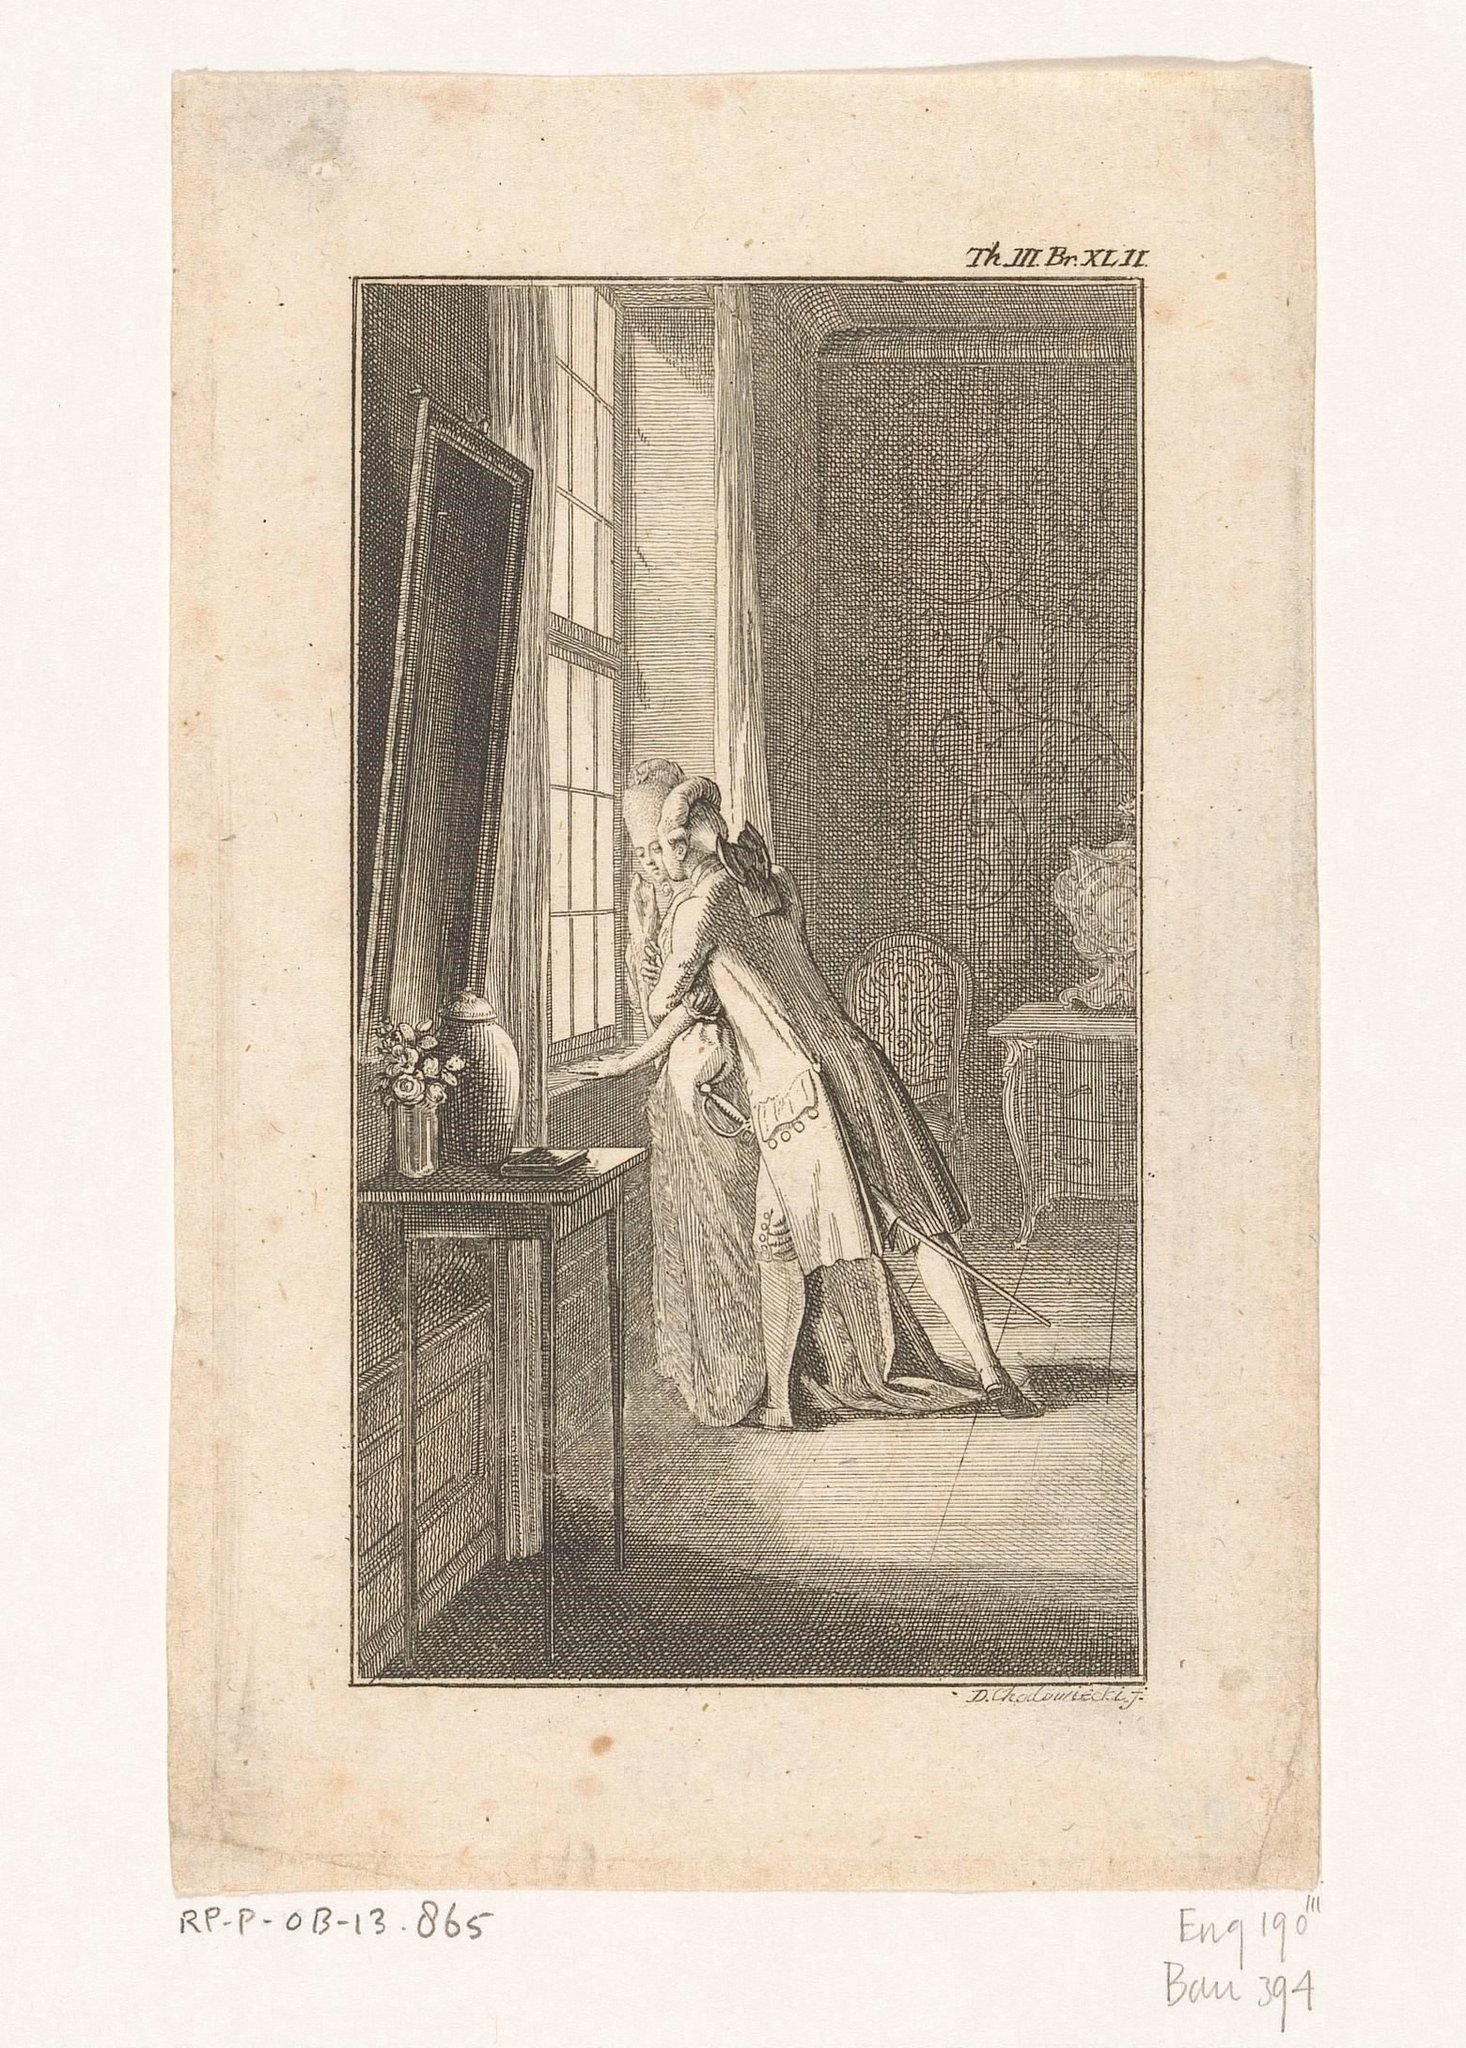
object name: print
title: Carl Ferdiner probeert Elise te omhelzen voor het raam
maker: daniel nikolaus chodowiecki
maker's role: draughtsman, print maker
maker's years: 1726-1801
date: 1777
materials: paper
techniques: etching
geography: berlin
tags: literature, (lovers) kissing each other, human figure at (open) window, seen from inside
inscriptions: collector's mark: Lugt 2228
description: Ook gebruikt in: Dusch, Johann Jakob. Geschichte Carl Ferdiners. 3 dln. Breslau en Leipzig: Johann Ernst Meyer, 1777-1780.